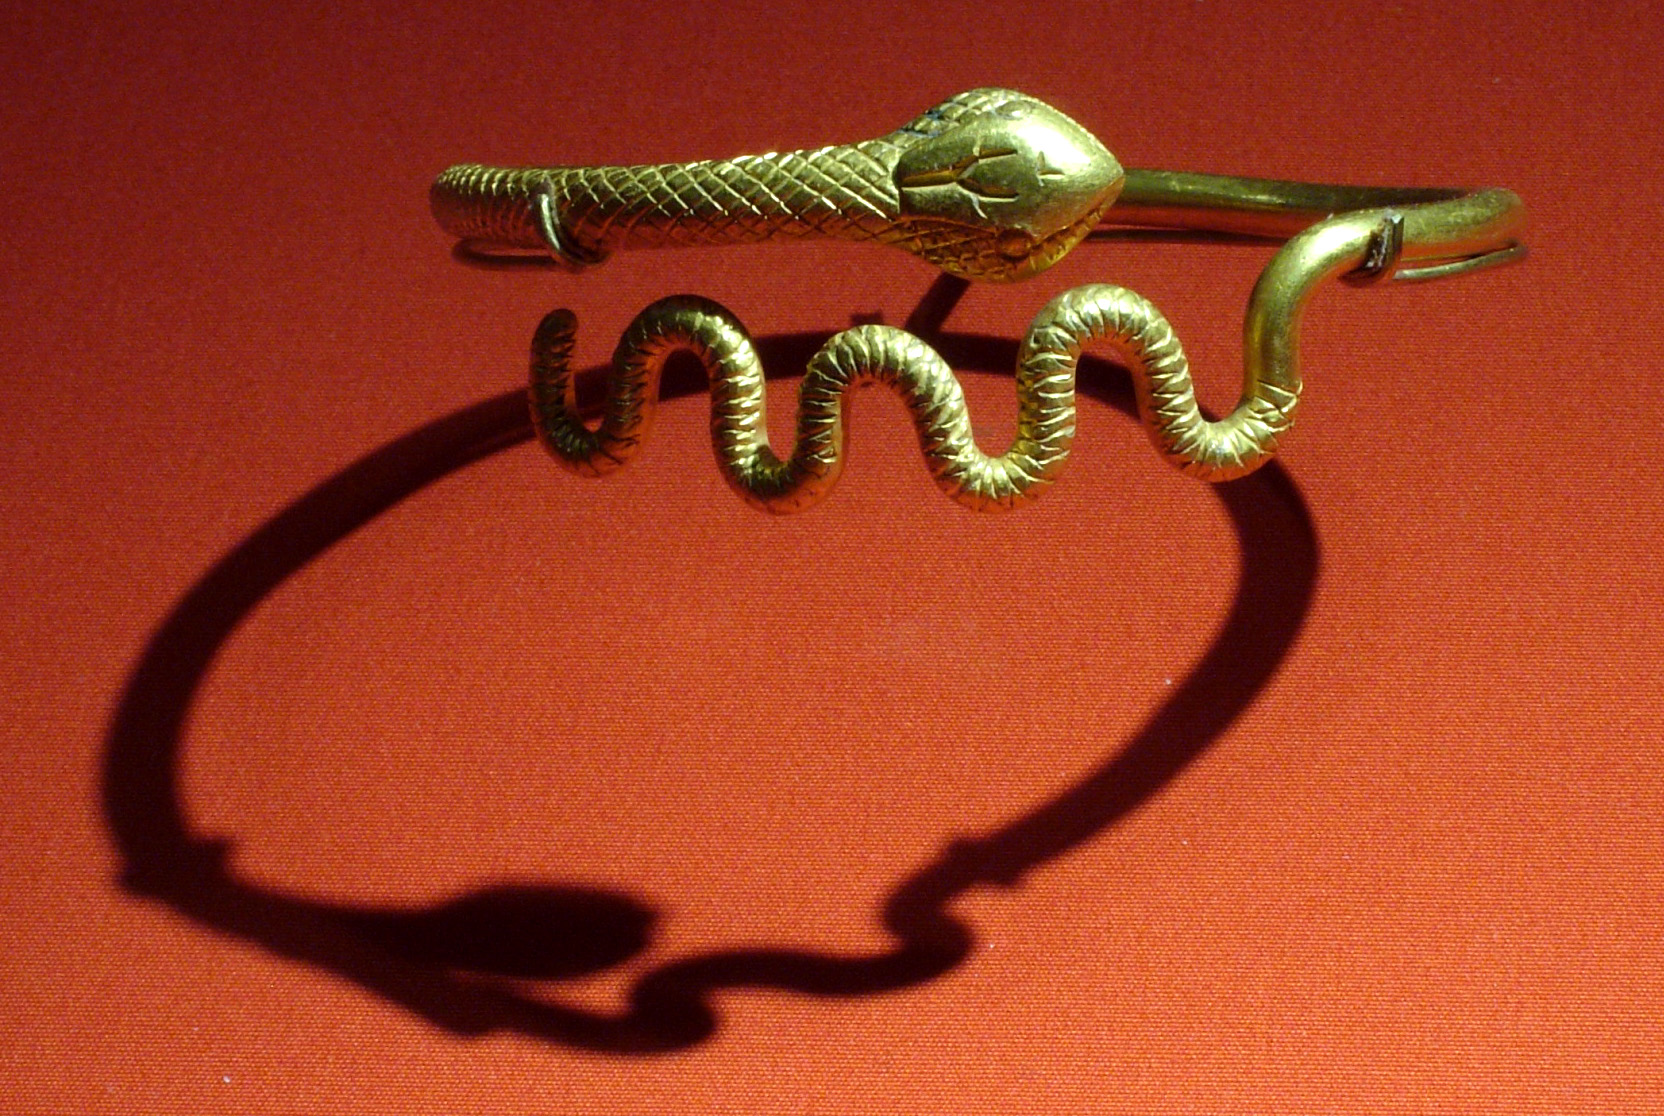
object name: bracelet, snake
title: Snake bracelet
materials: gold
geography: egypt